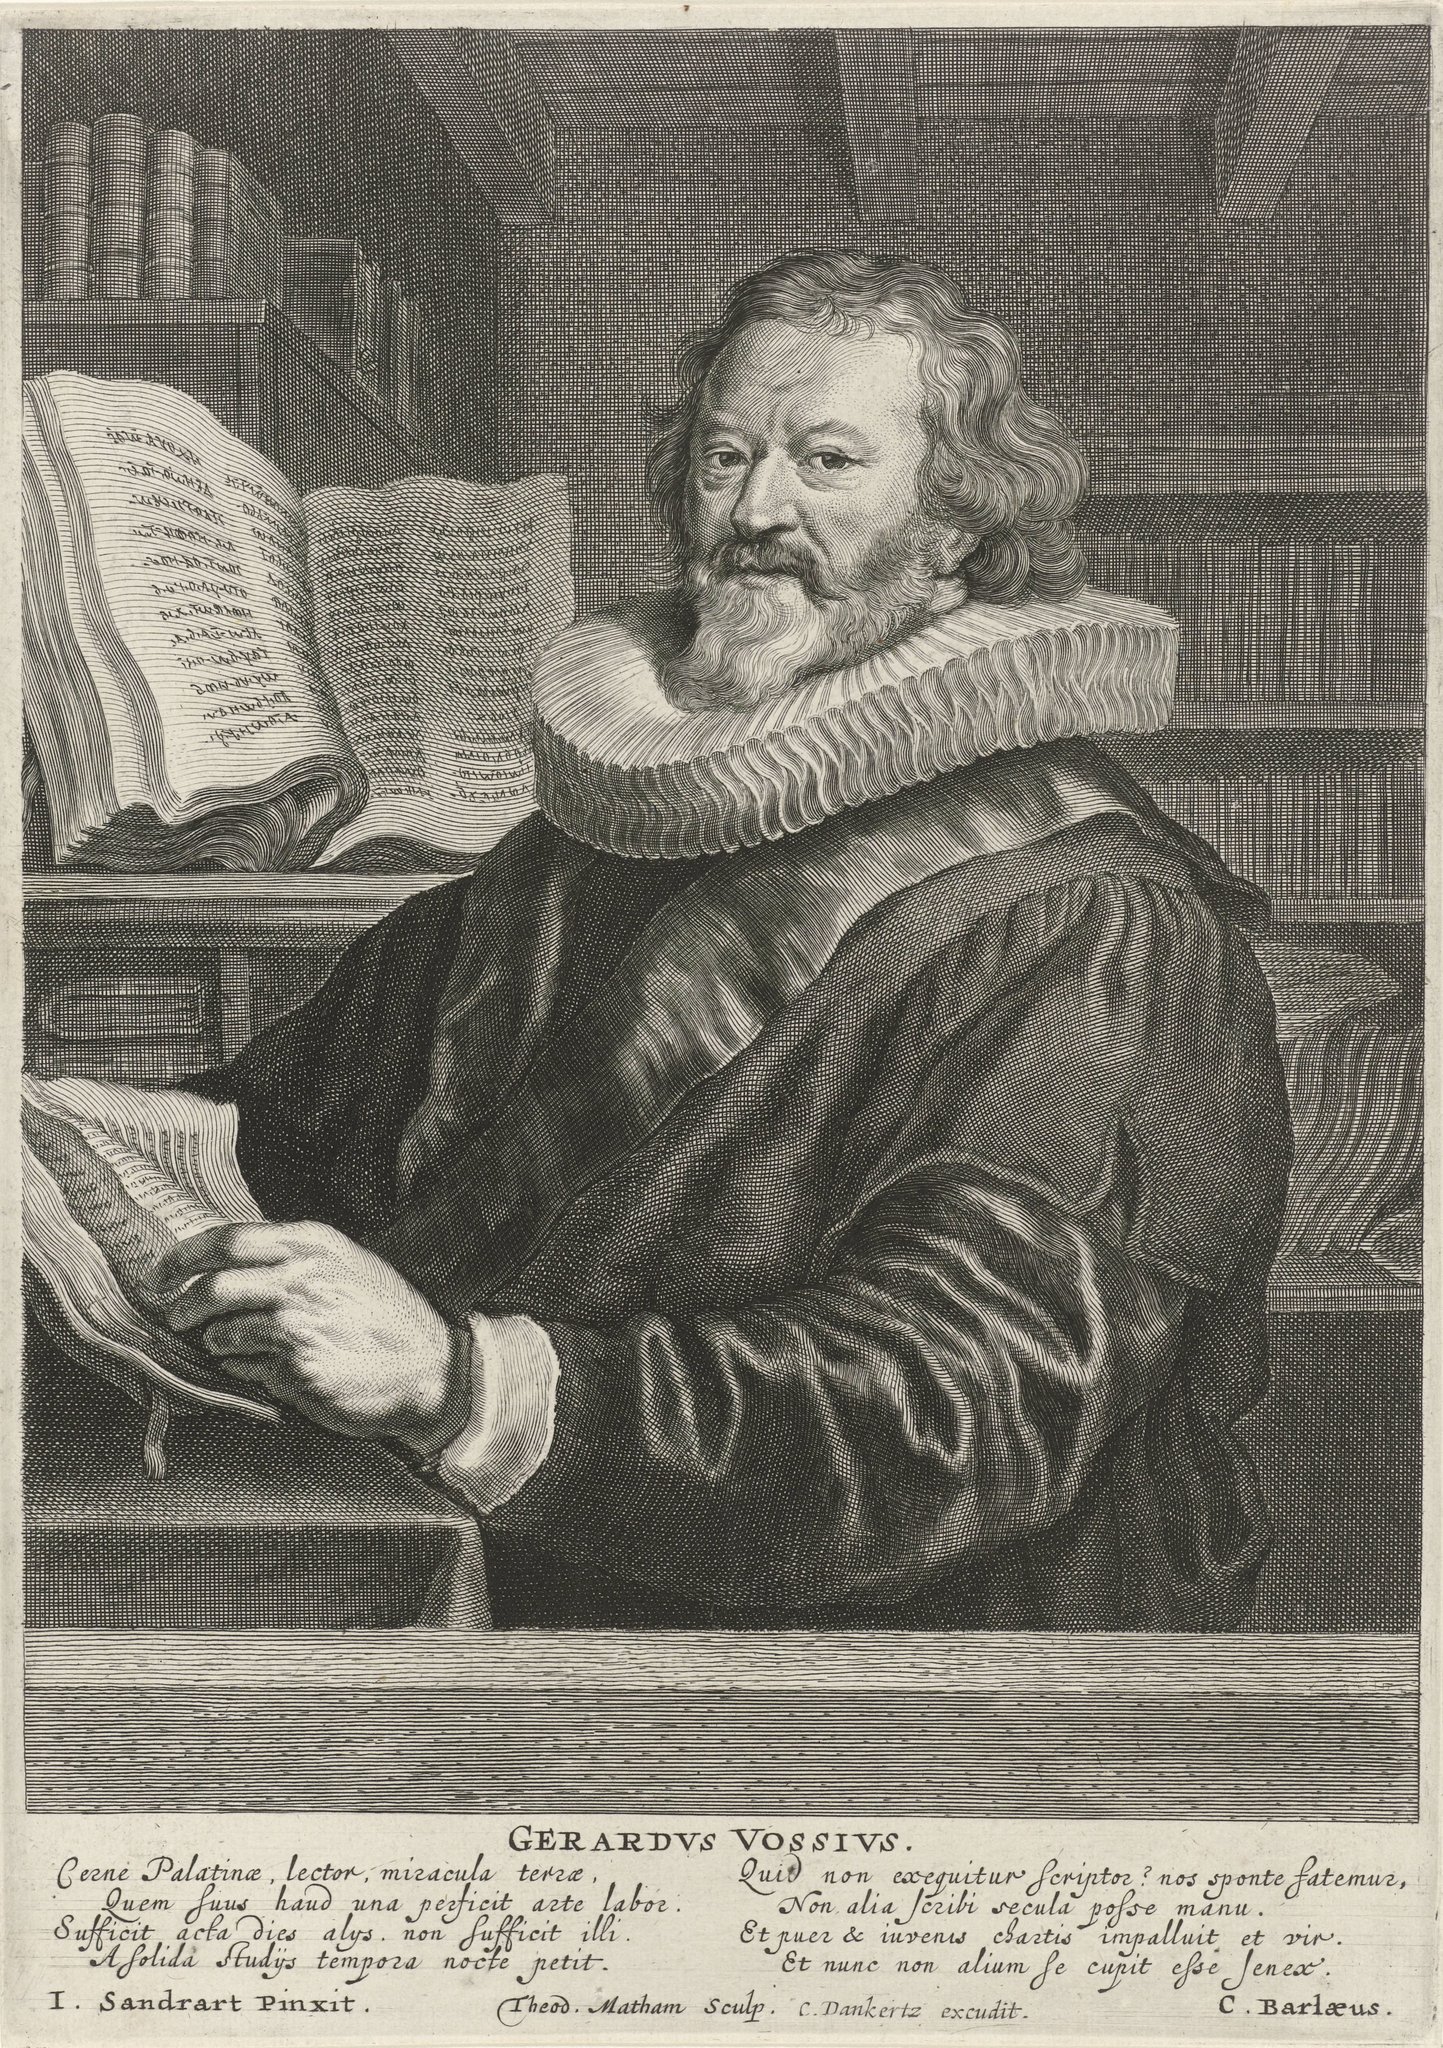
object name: print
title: Portret van Gerardus Joannes Vossius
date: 1630-1676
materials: paper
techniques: engraving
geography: amsterdam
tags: amsterdam, gerardus joannes vossius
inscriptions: collector's mark: Lugt 240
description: Portret van de schrijver en theolooog Gerardus Joannes Vossius.